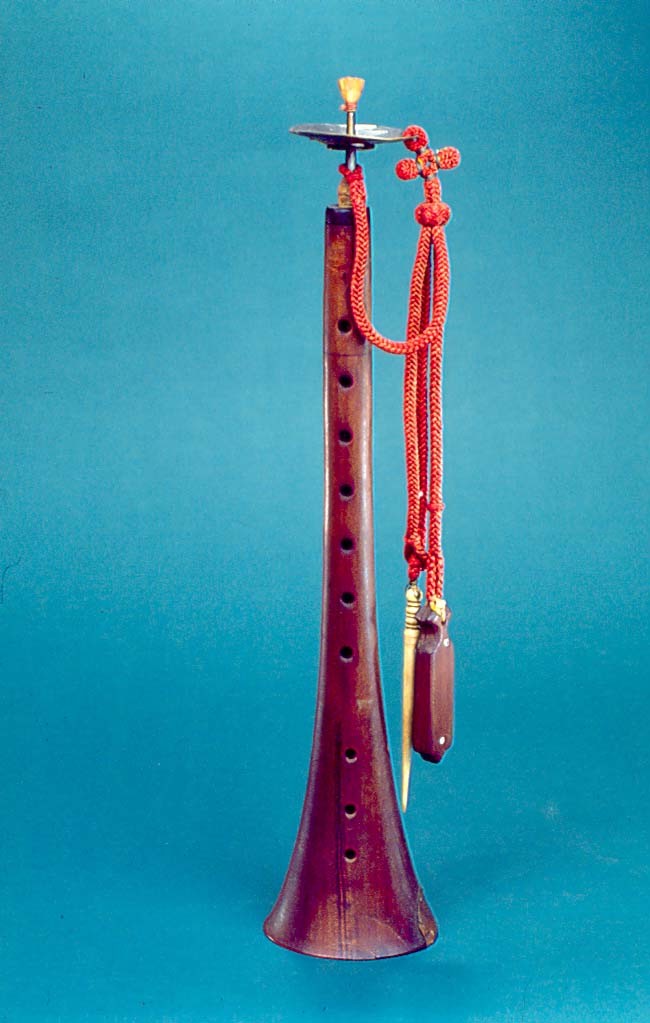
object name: rhaita al ghaita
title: Rhaita (Al ghaita)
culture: moroccan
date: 1850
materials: bone, metal, wood